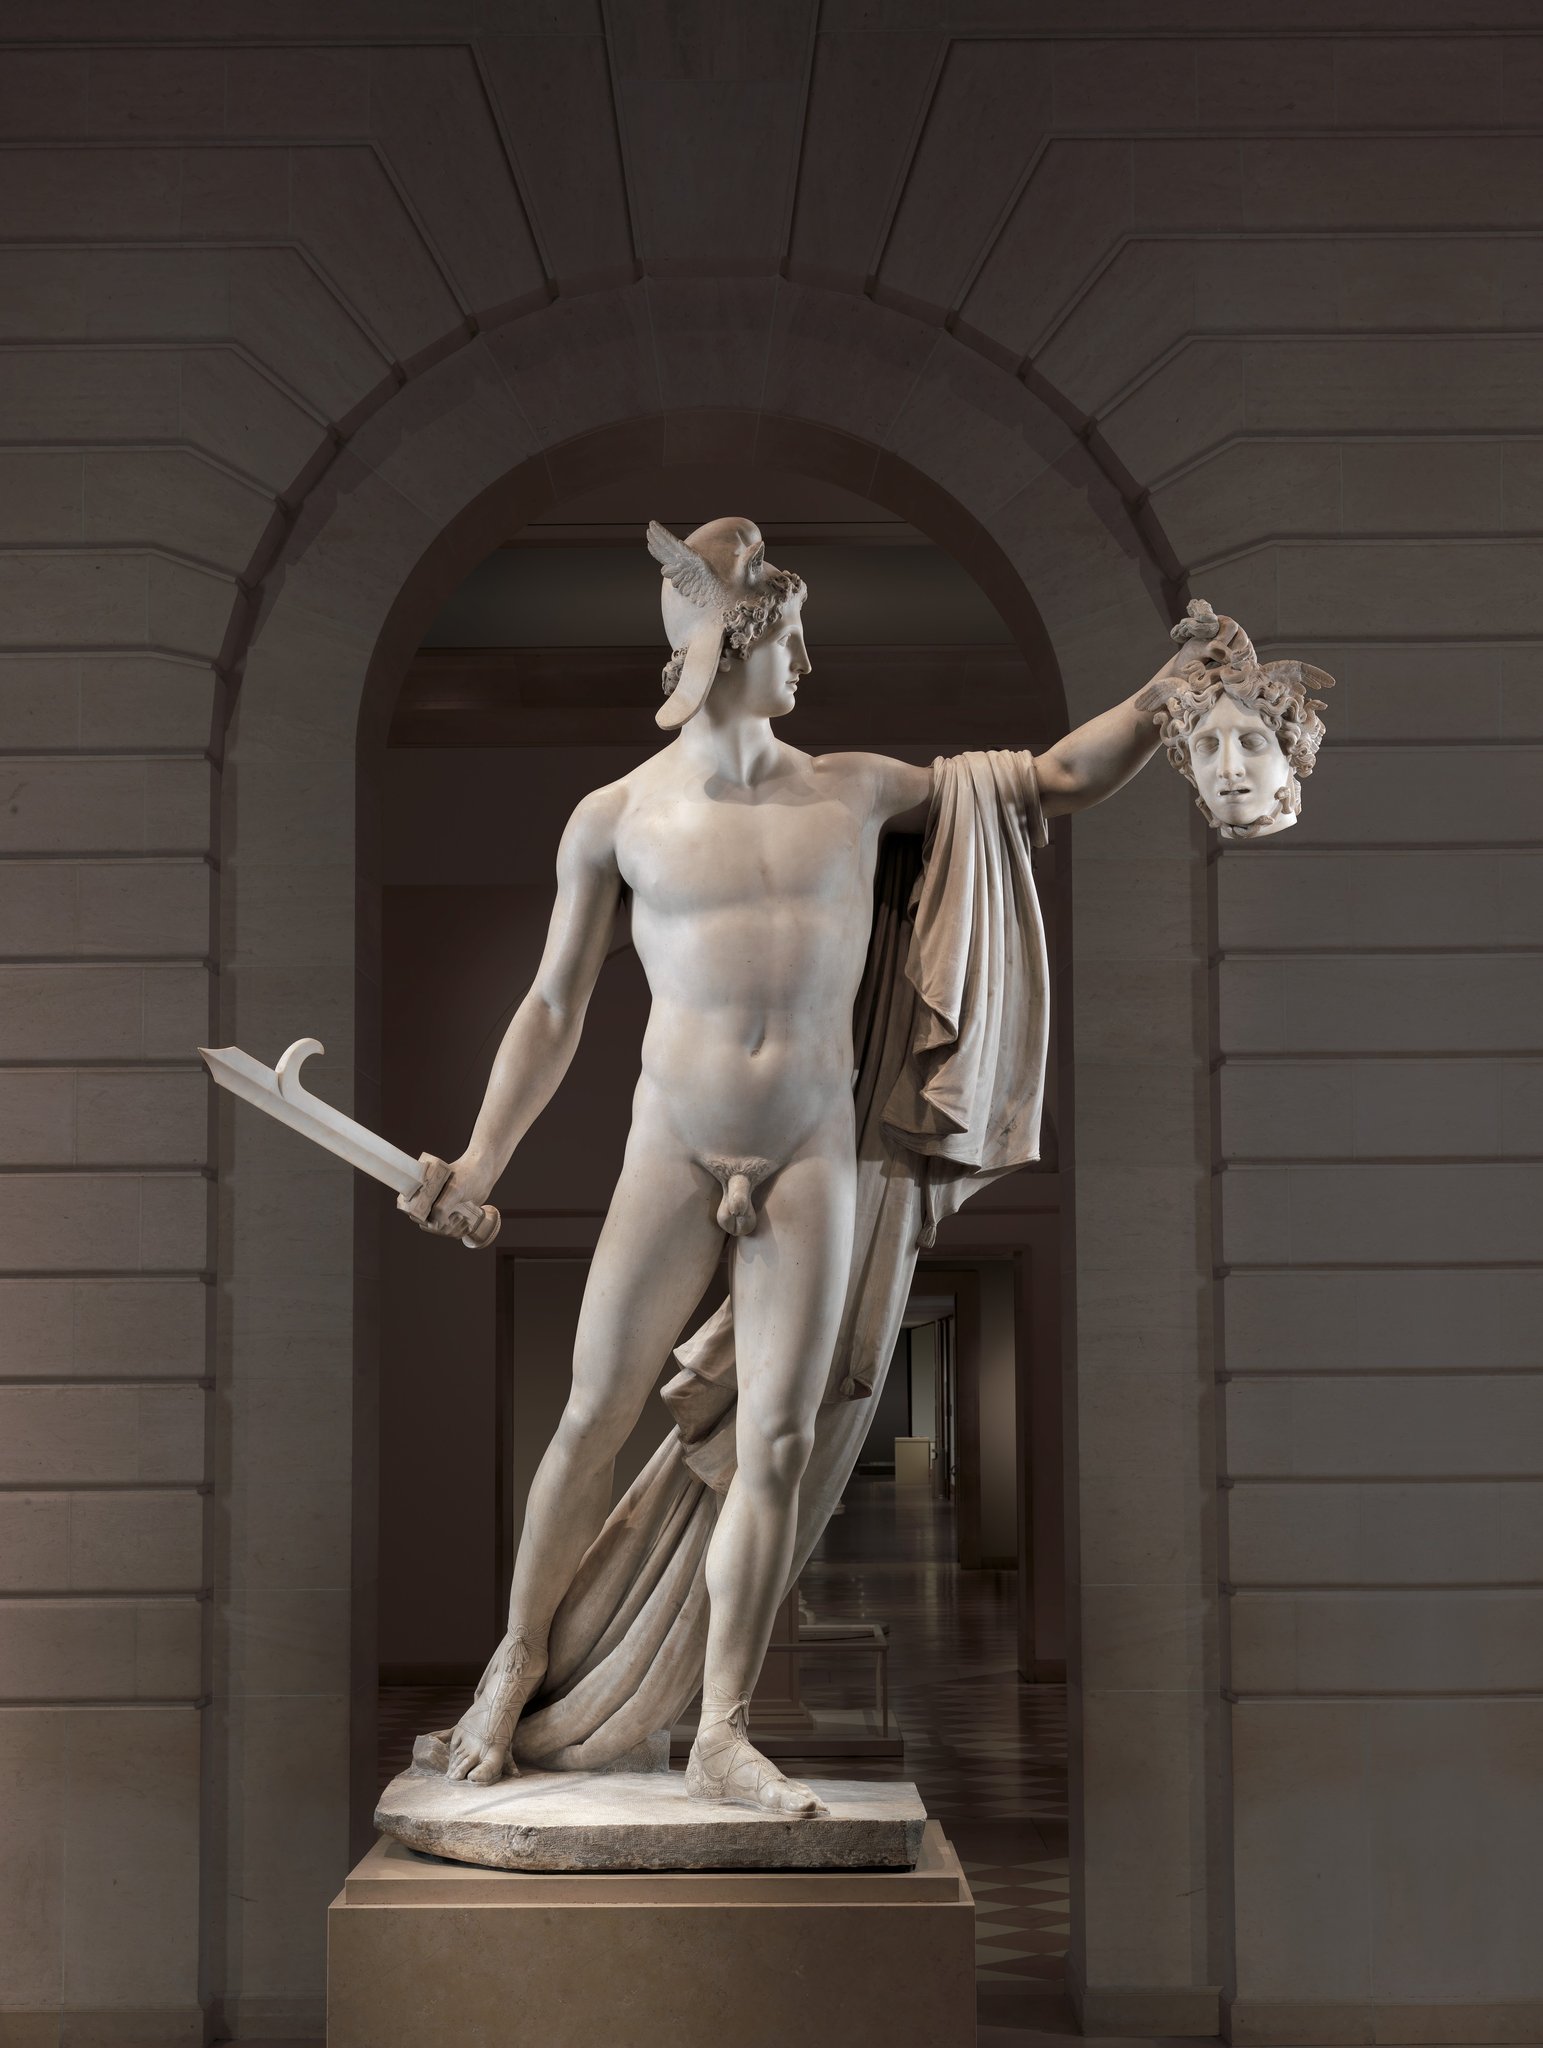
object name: statue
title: Perseus with the Head of Medusa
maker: antonio canova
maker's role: artist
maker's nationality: italian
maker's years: 1757-1822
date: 1804-1806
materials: marble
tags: swords,male nudes,medusa,perseus